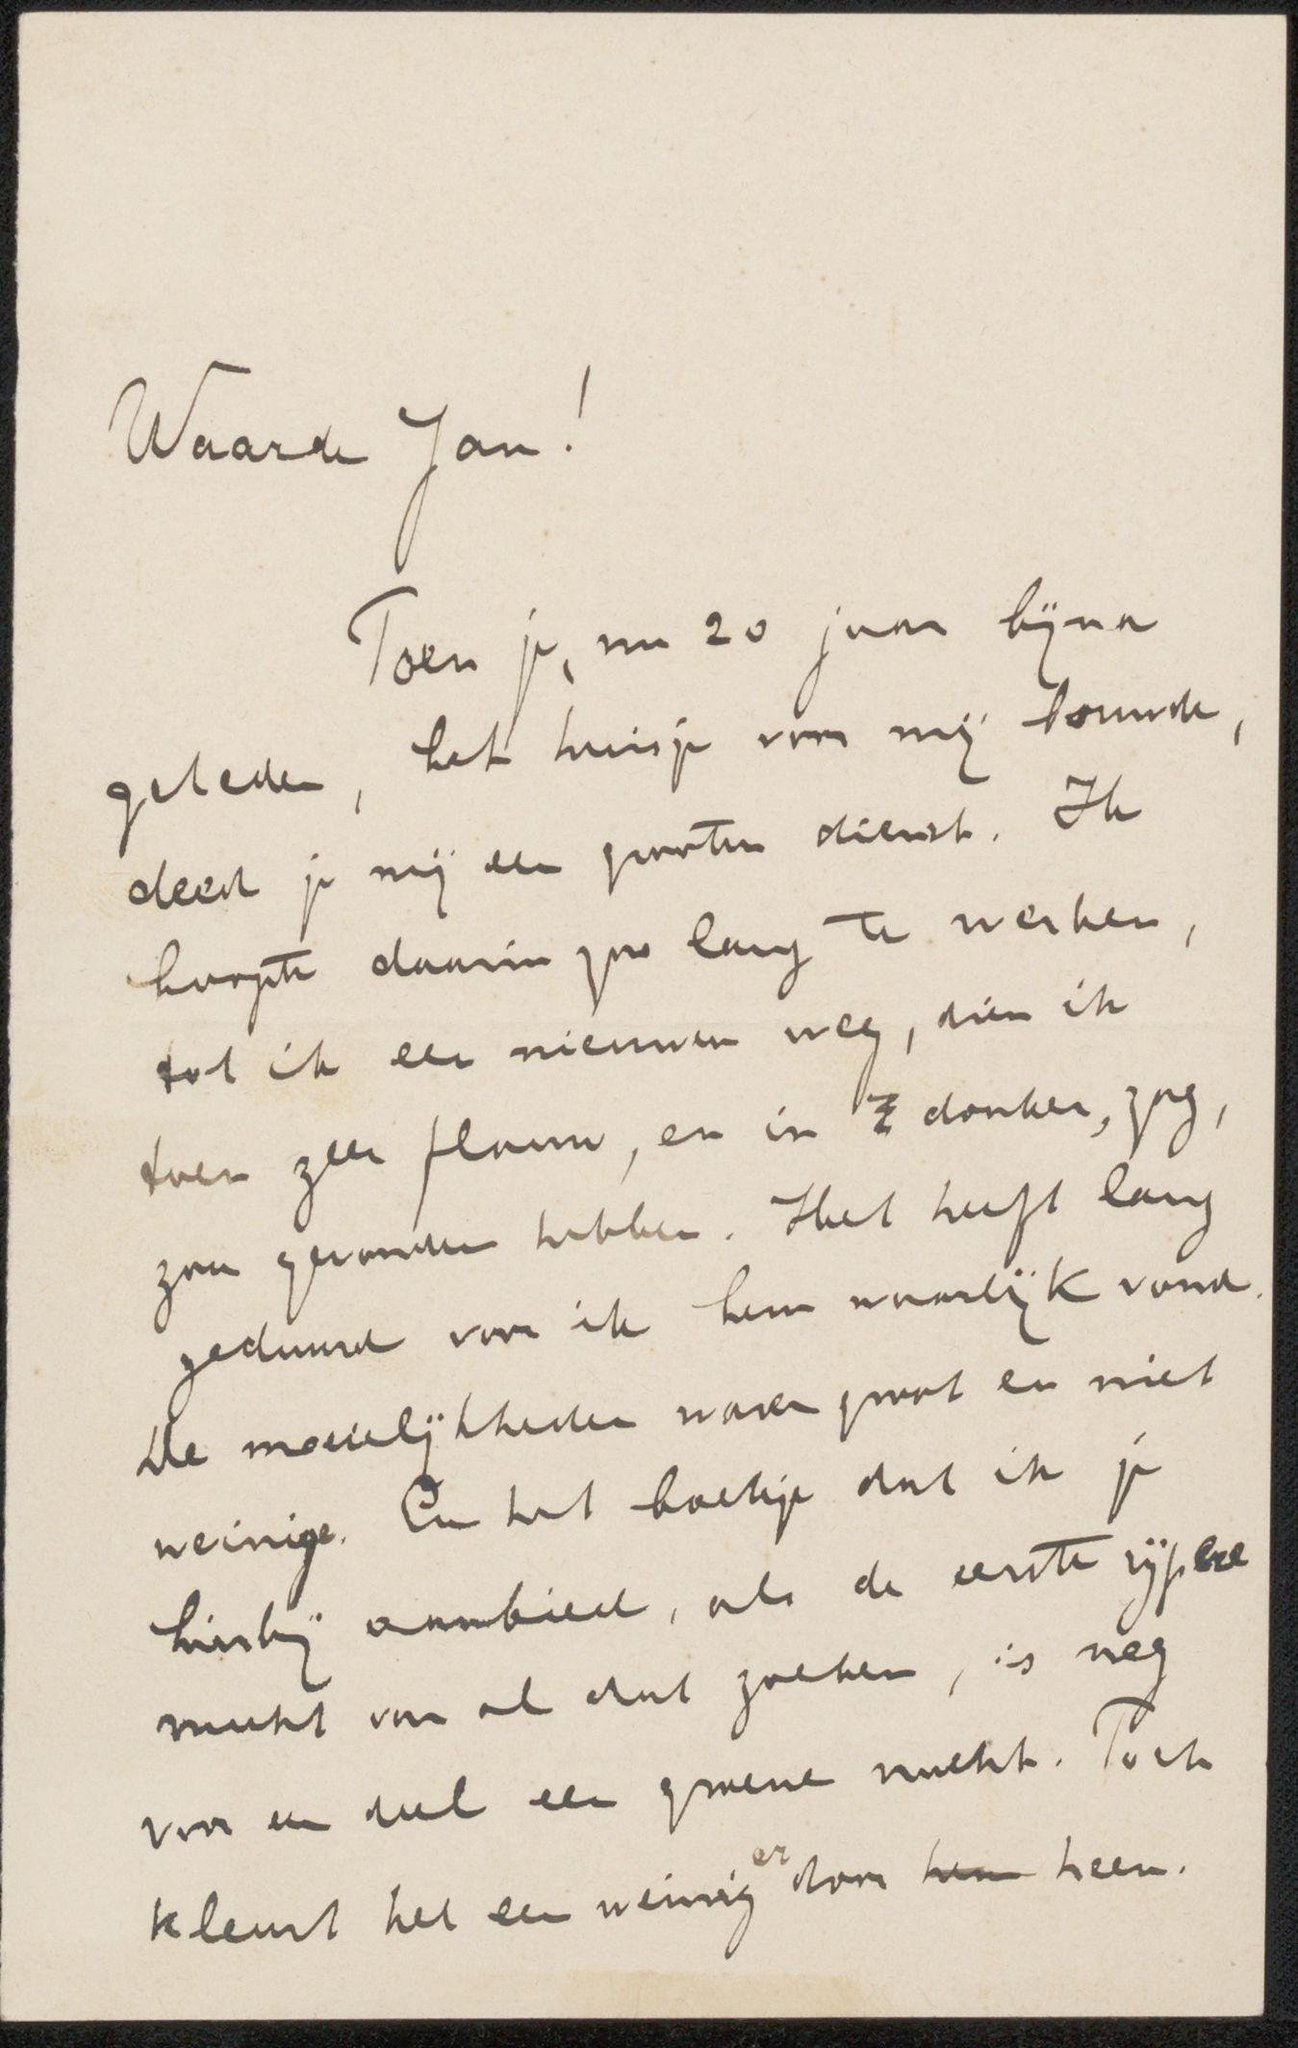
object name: letter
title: Brief aan Jan Veth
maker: herman gorter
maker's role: letterkundige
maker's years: 1864-1927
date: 1912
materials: ink, paper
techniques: pen, writing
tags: dordrecht, amsterdam, painter, draughtsman, designer, jan veth, printed matter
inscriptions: collector's mark: ‘RPK’